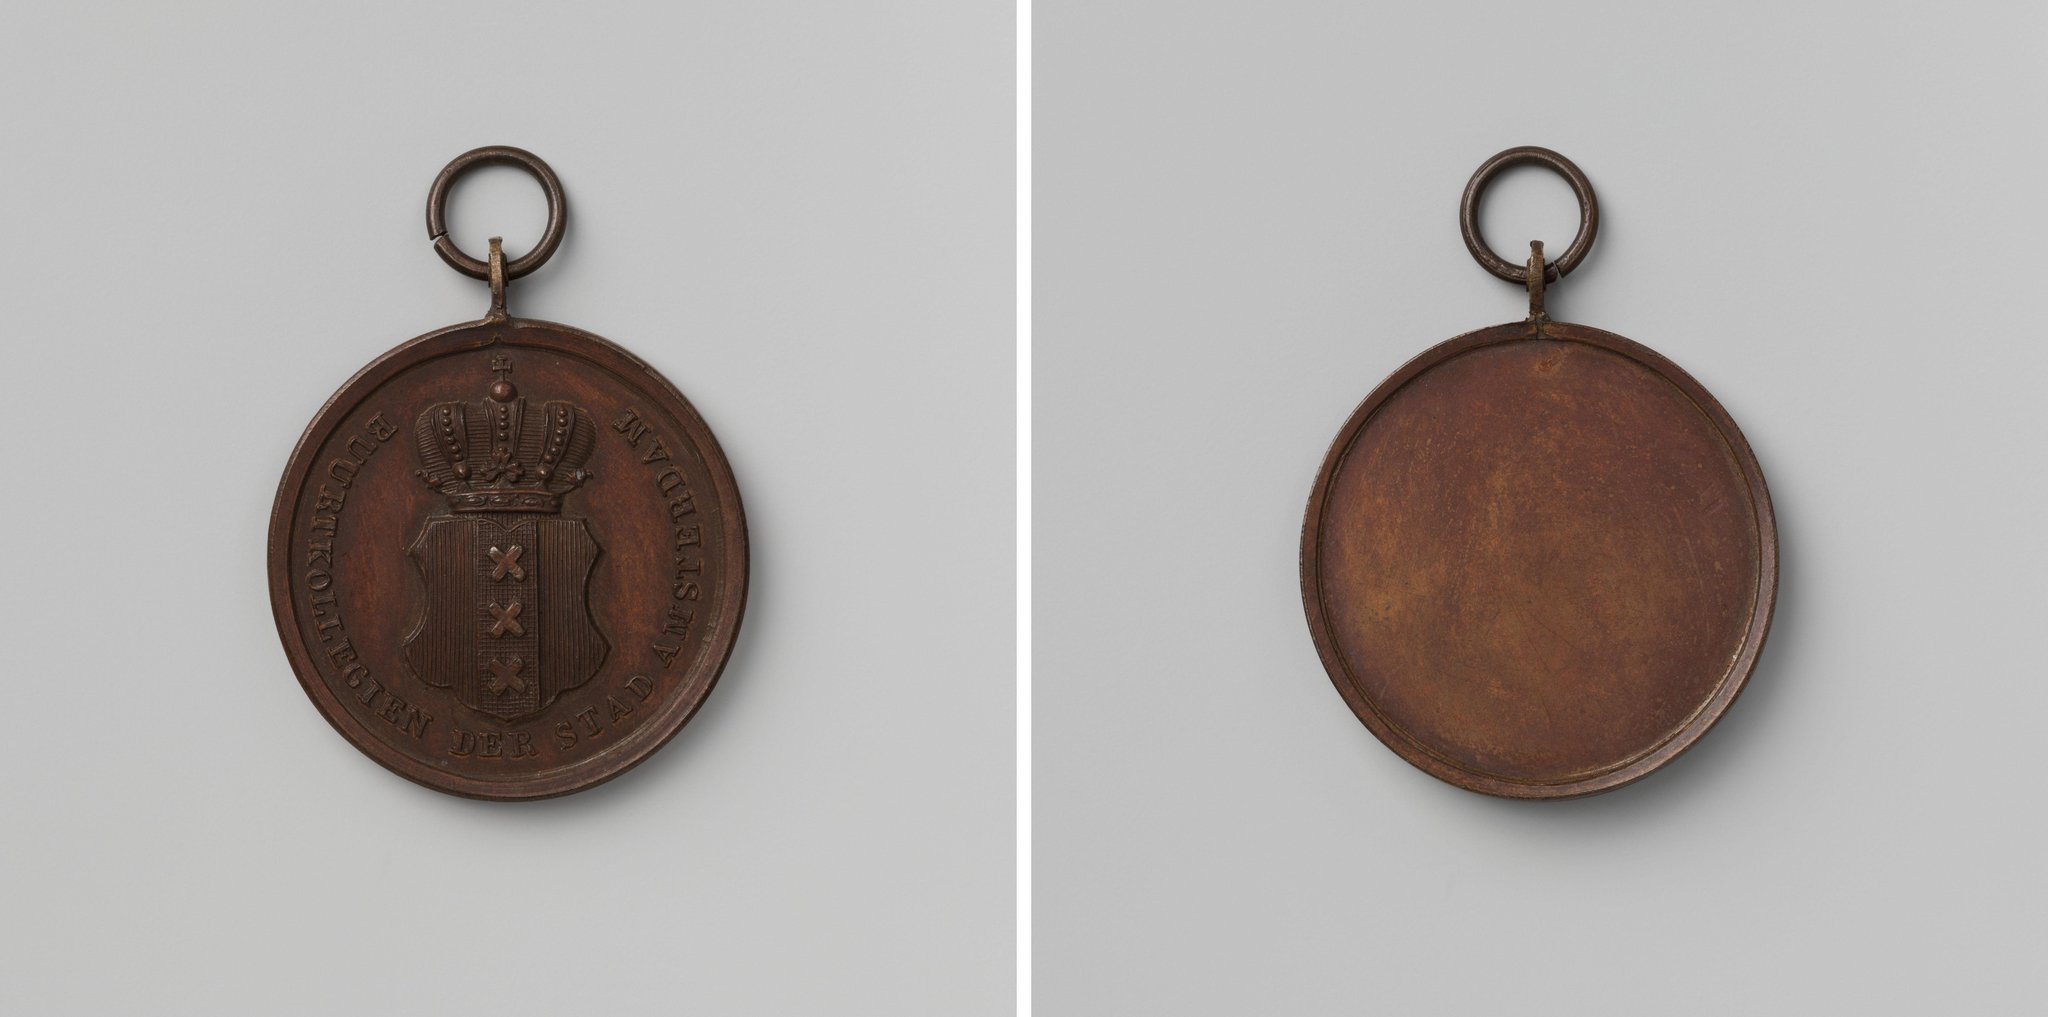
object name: insignia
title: Buurtcommissaris van Amsterdam, draagteken om toegang te verlenen tot het terrein van de brand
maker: Anonymous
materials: bronze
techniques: striking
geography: amsterdam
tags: amsterdam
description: Eenzijdige bronzen penning met draagoog en draagring. Voorzijde: gekroond wapenschild binnen omschrift. Keerzijde: blanco.